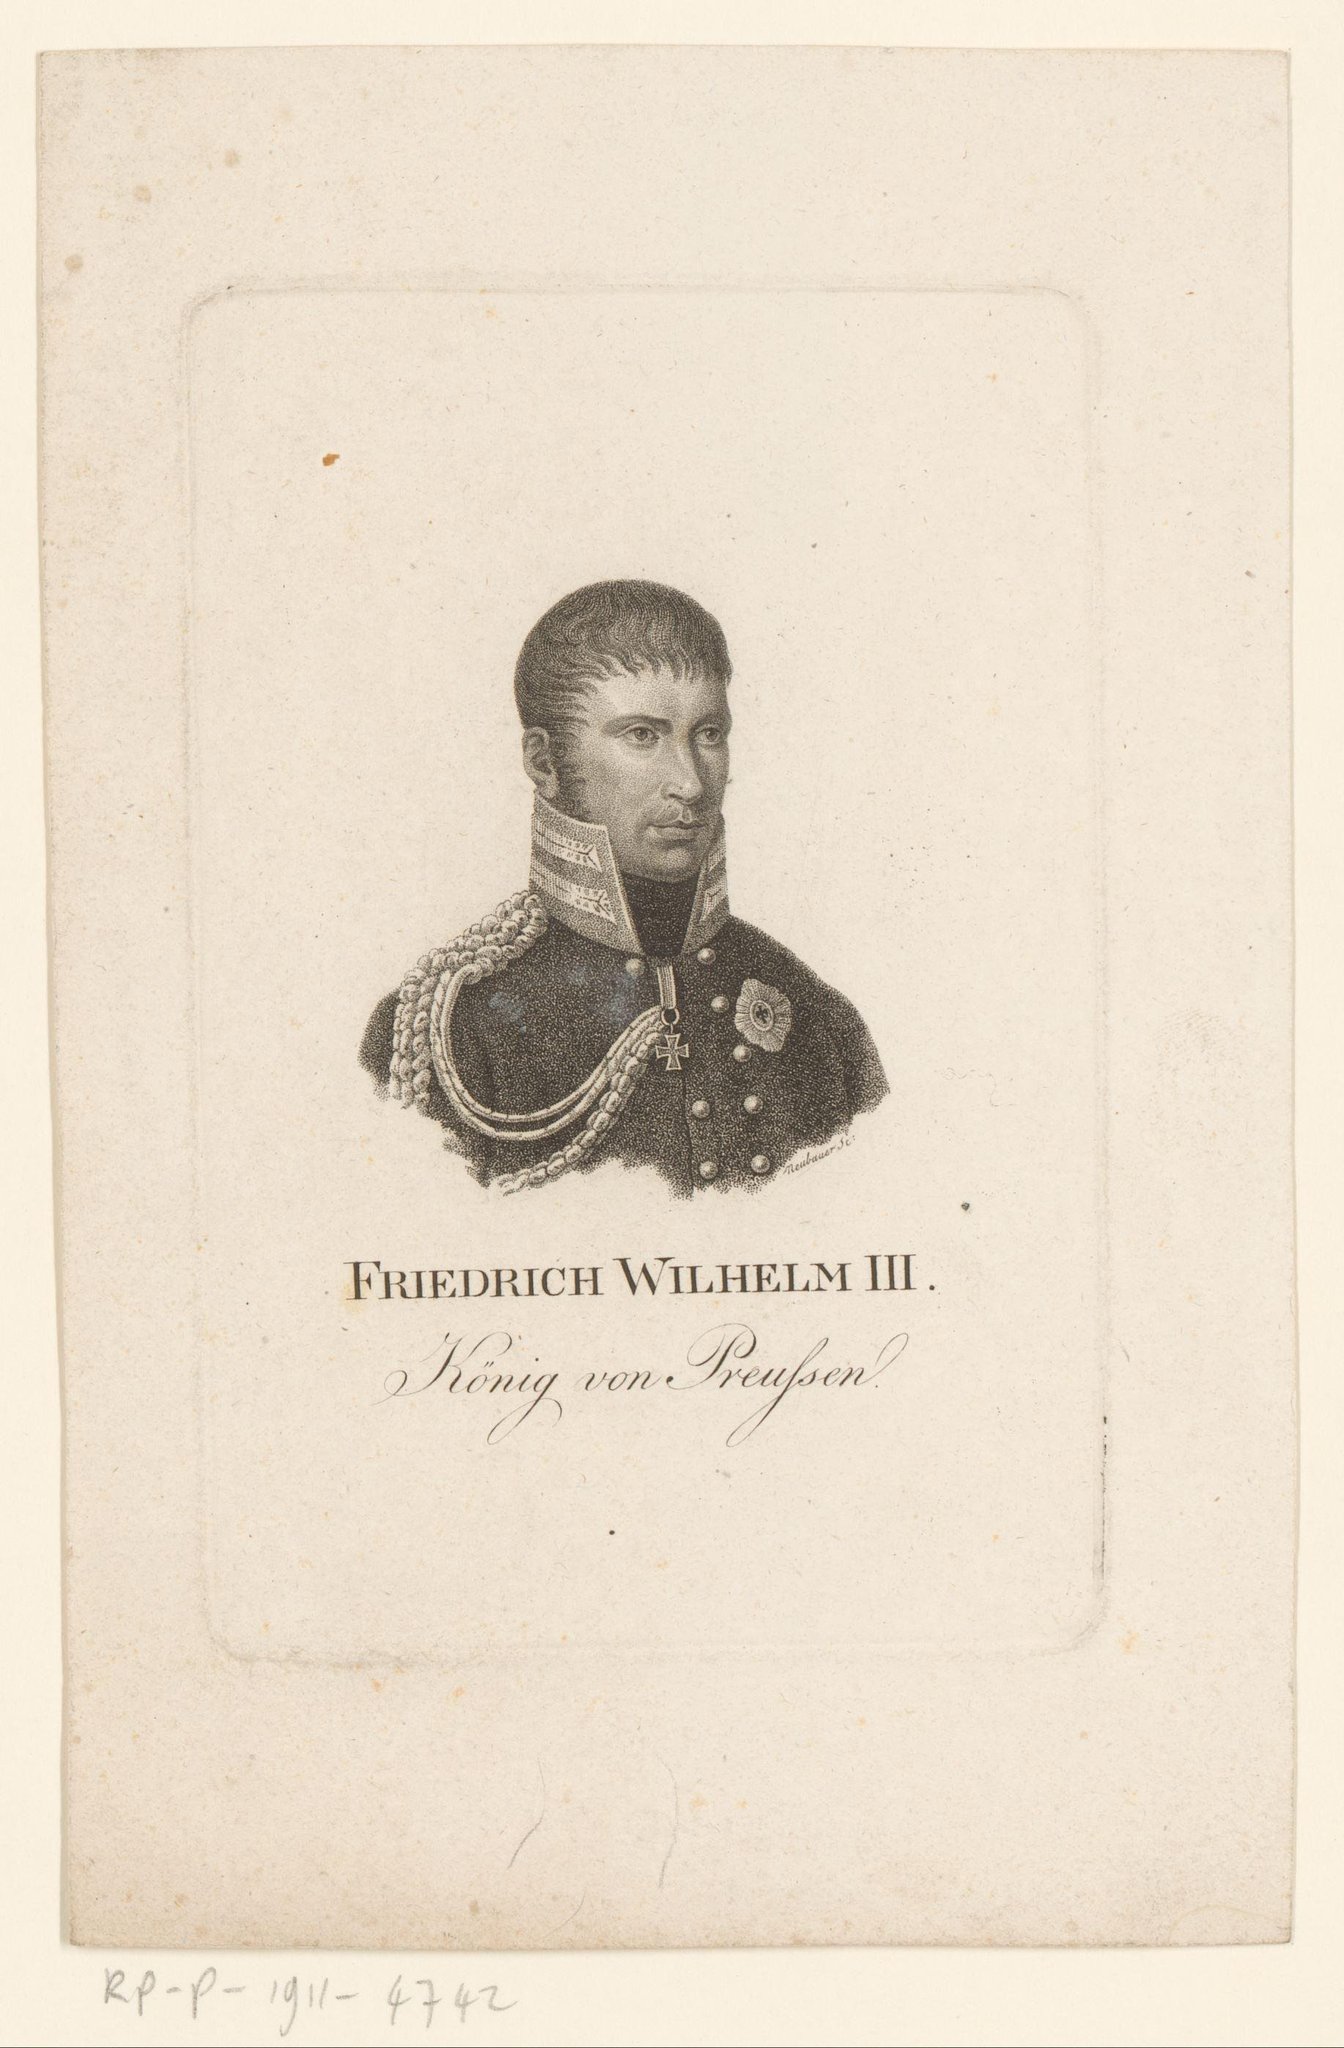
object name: print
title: Portret van Friedrich Wilhelm III, koning van Pruisen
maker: friedrich ludwig neubauer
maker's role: print maker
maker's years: 1767-1828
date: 1797-1828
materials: paper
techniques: engraving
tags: berlin, frederik willem iii koning van pruisen, knighthood order (with name) - insignia of a knighthood order, e.g.: badge, chain (with name of order), historical persons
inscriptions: collector's mark: Lugt 2228